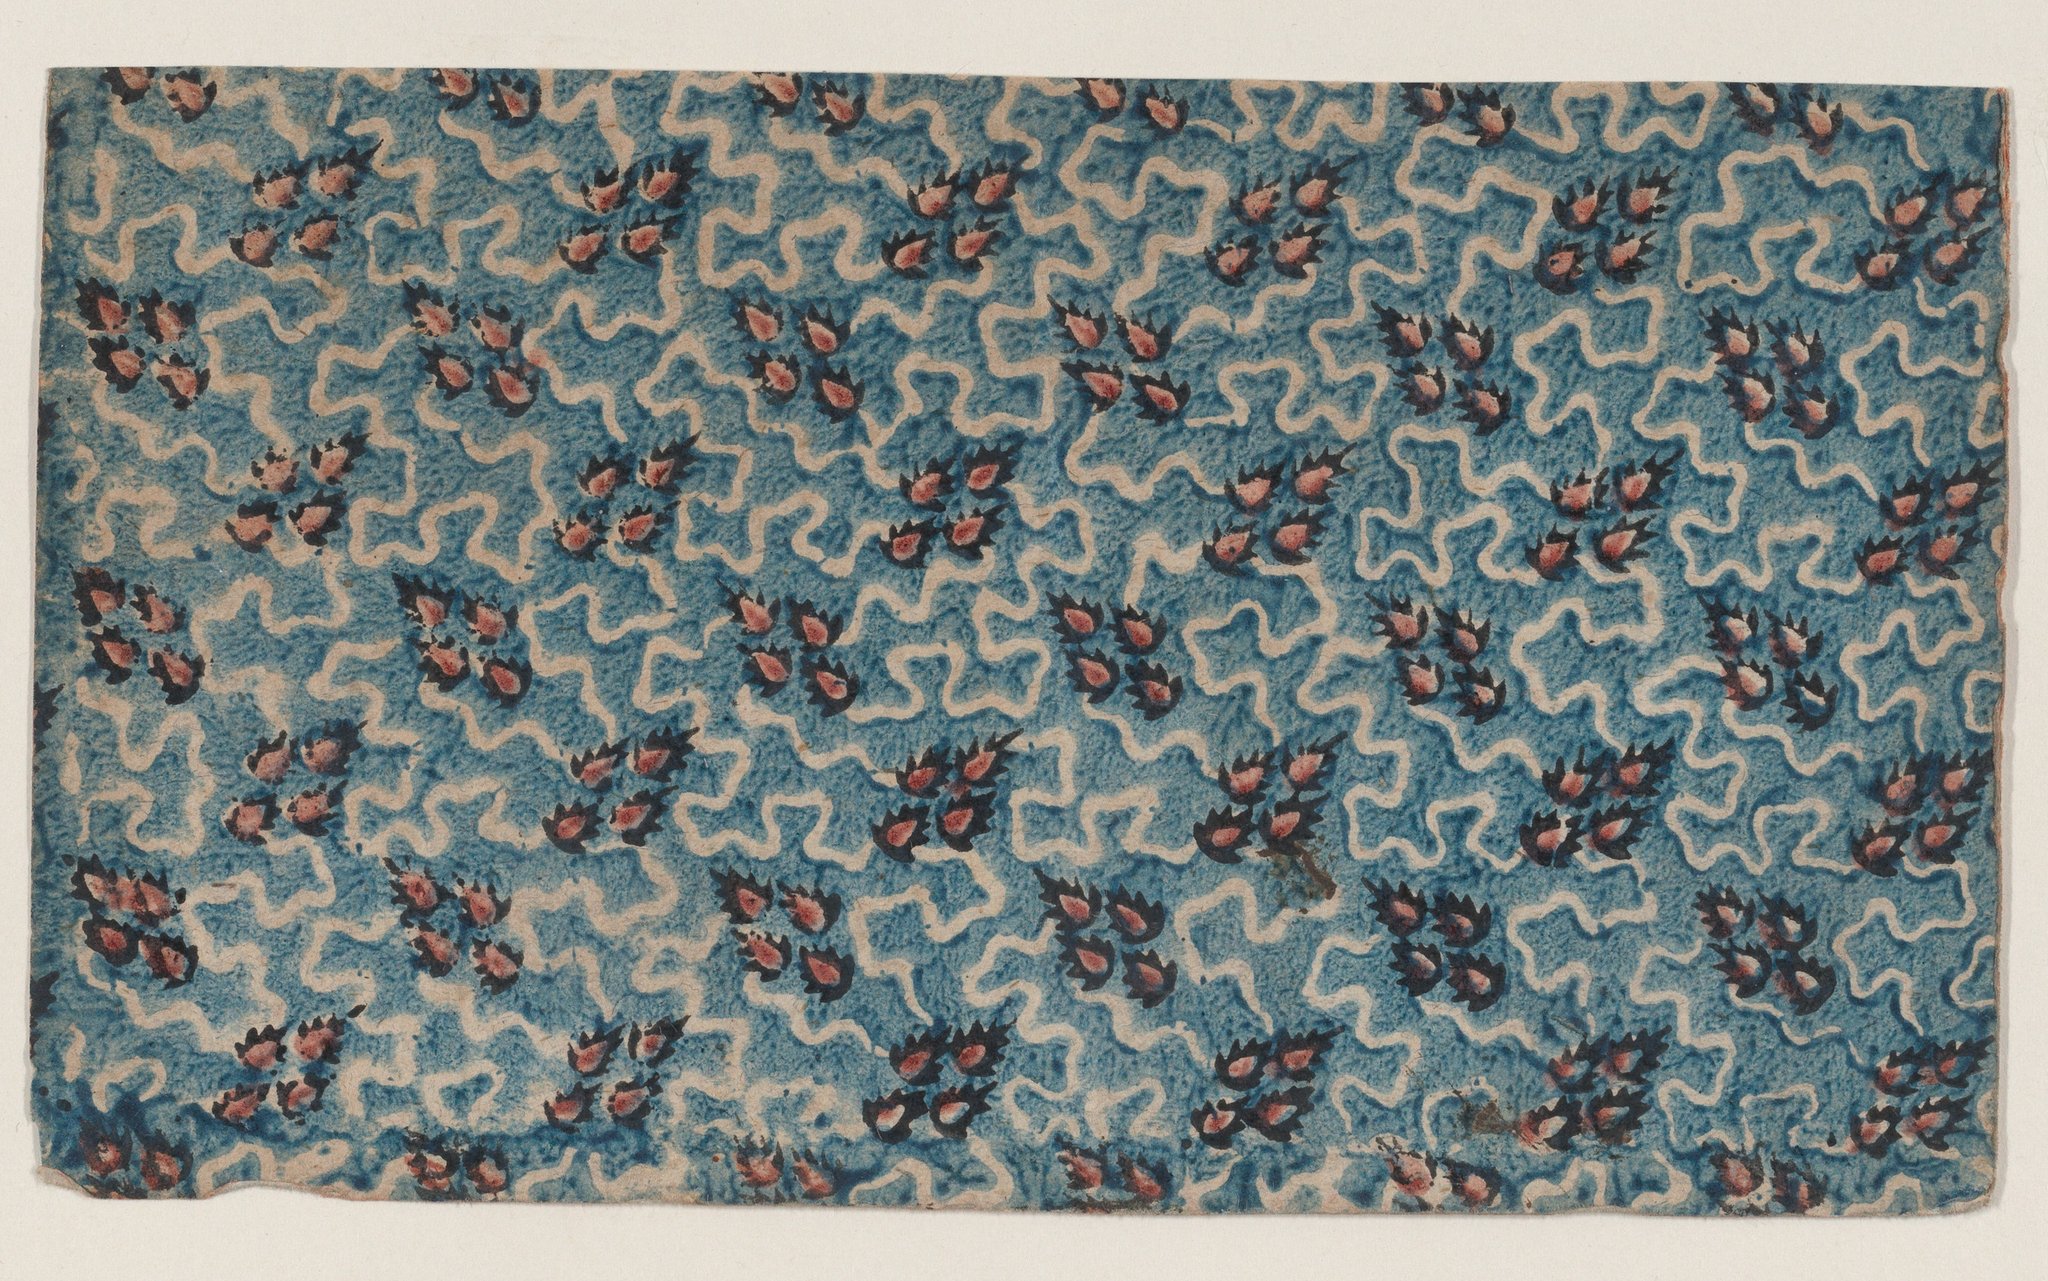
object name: print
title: Sheet with overall abstract pattern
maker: Anonymous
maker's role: artist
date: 1801-1900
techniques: relief print